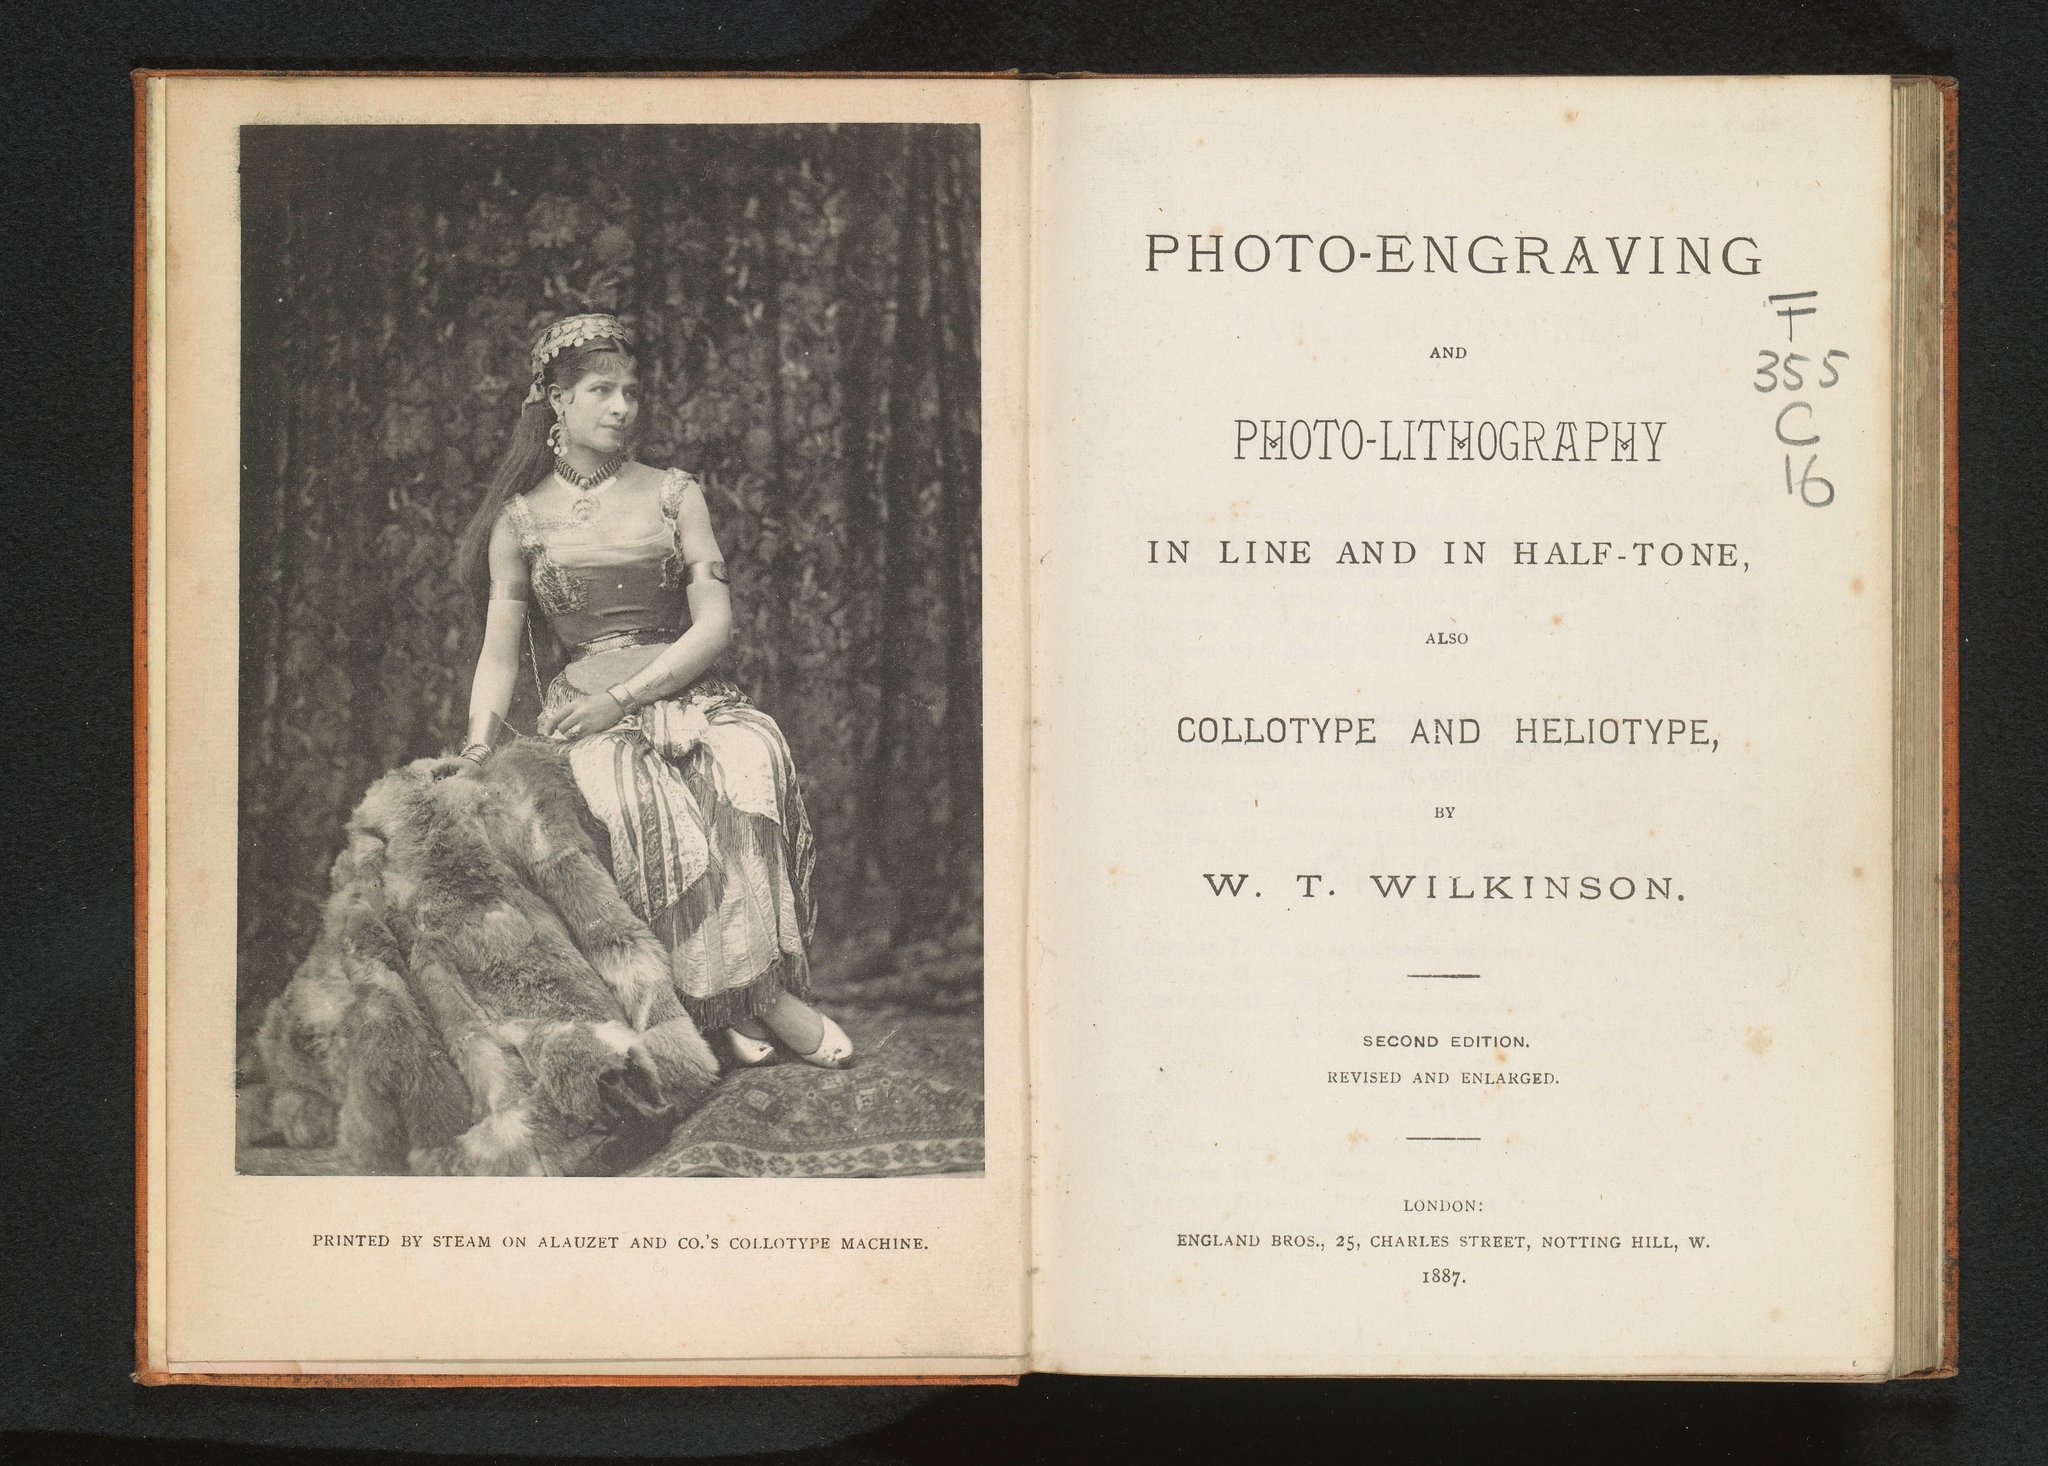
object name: book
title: Photo-engraving and photo-lithography in line and in half-tone, also collotype and heliotype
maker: w.t. wilkinson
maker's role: auteur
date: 1887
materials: cardboard, linen, paper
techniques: photograph, printing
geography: london